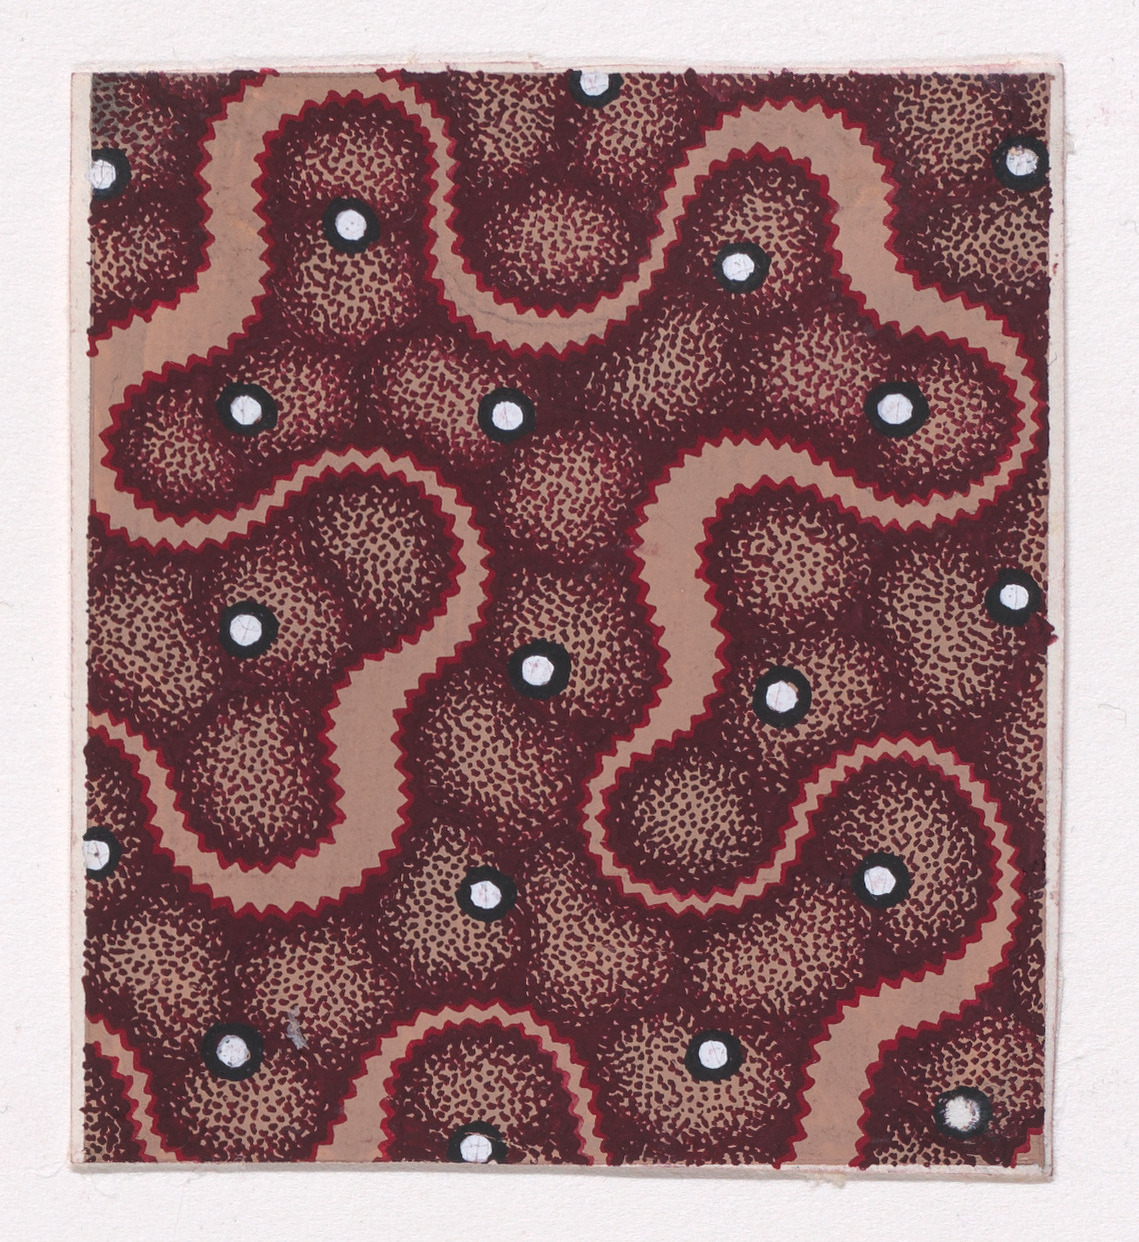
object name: drawing ornament architecture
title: Textile Design with a Ribbon Forming a Vermicular Pattern and Splattered Pearls over an Abstract Honeycomb Pattern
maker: anonymous, alsatian, 19th century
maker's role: artist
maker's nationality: alsatian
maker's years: 1800-1900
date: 1840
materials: gouache